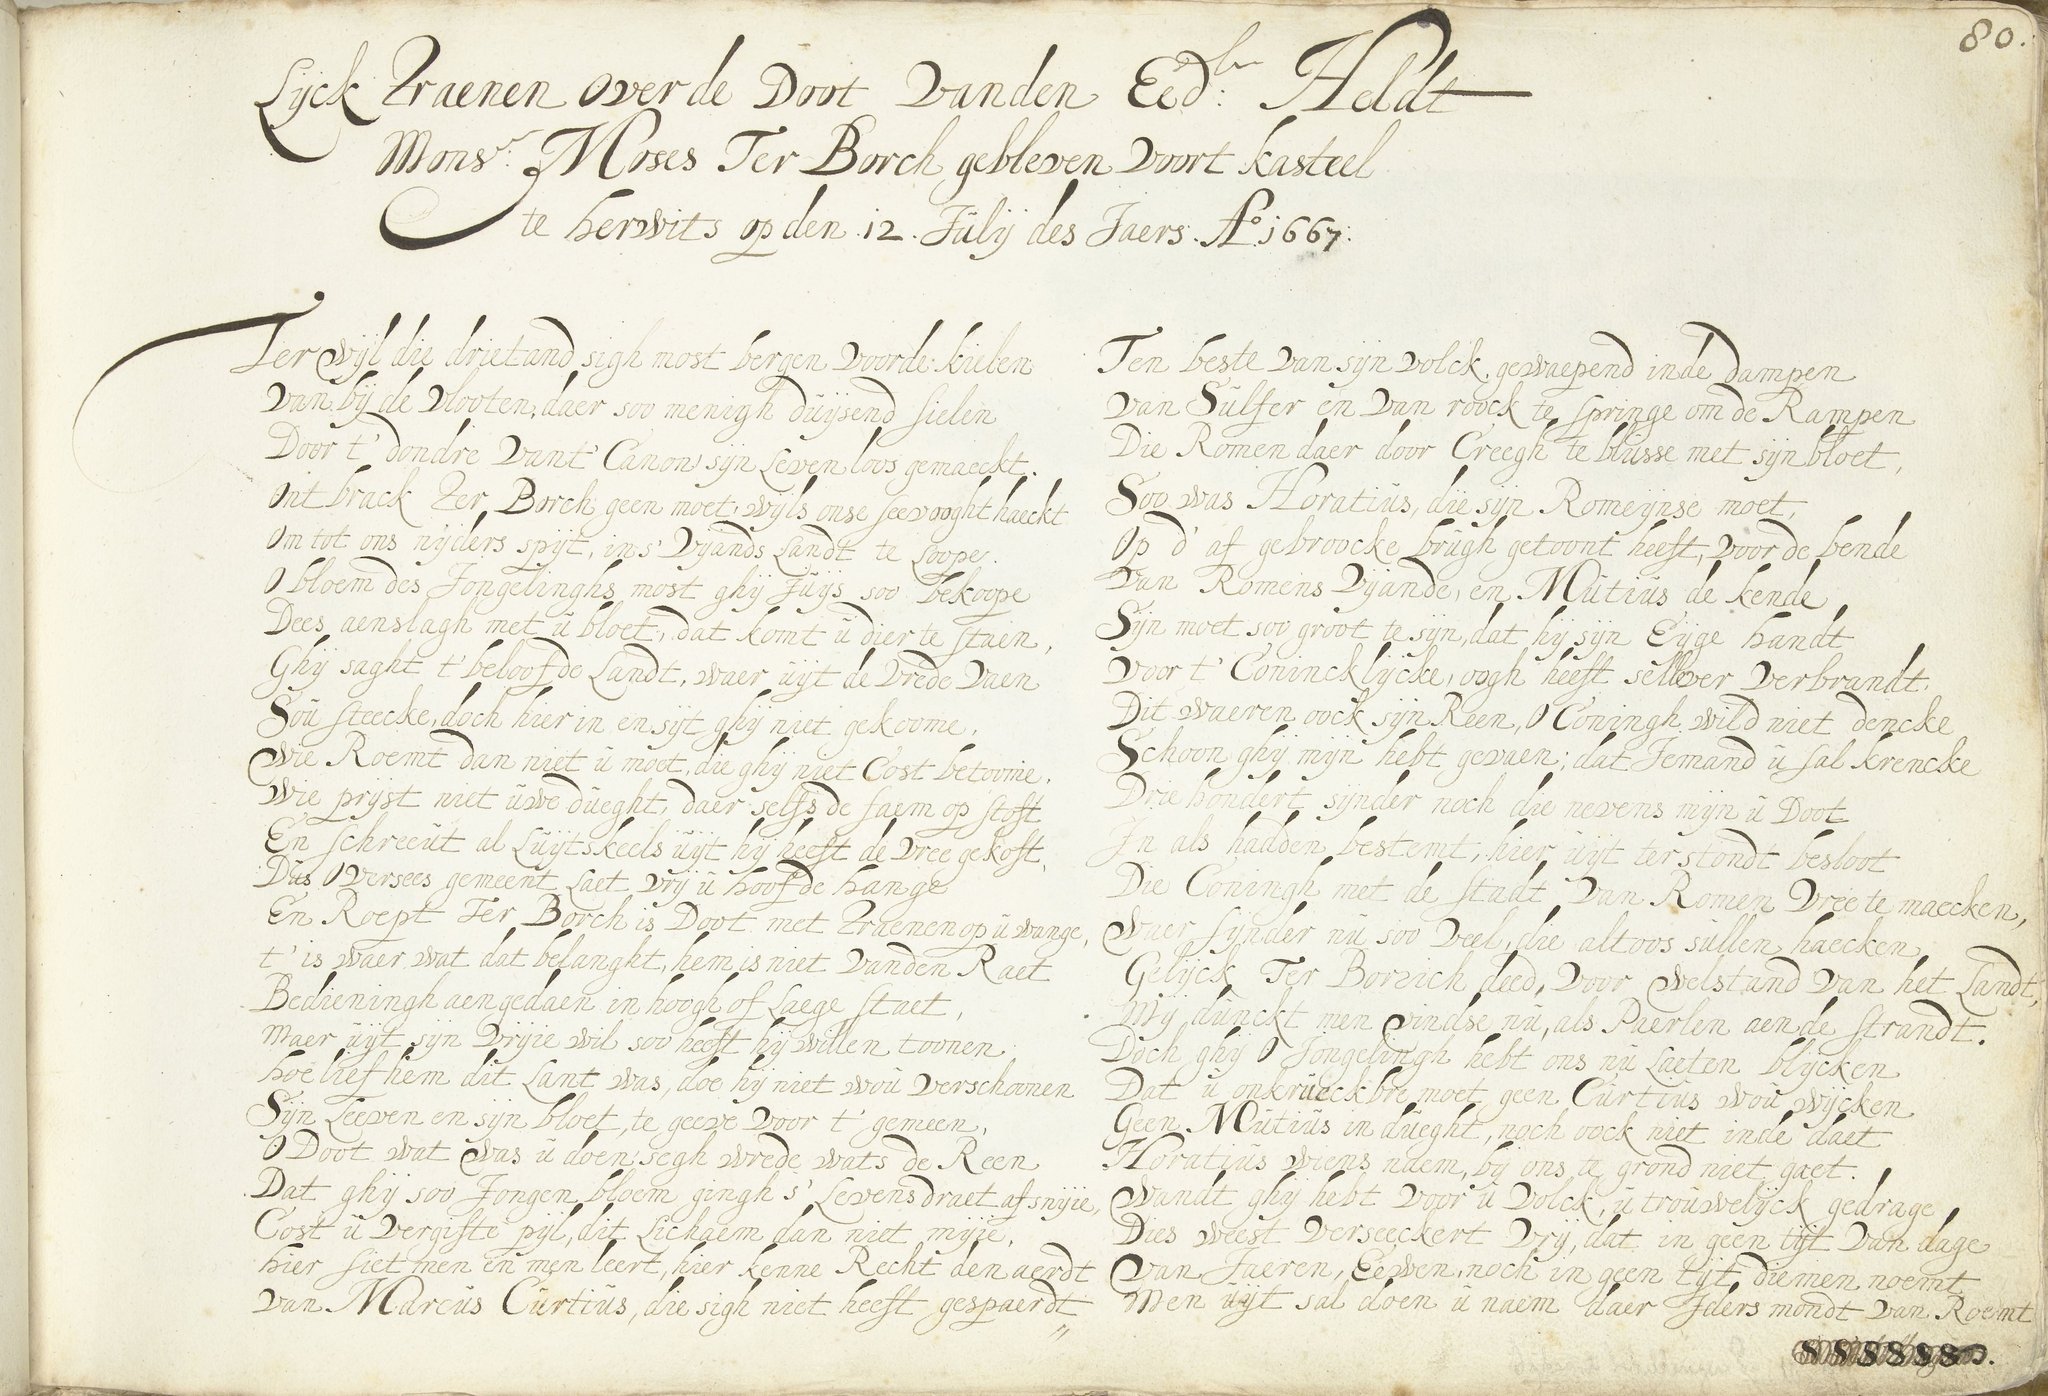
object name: poem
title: Rouwgedicht voor Moses ter Borch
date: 1667-1670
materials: ink, paper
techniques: writing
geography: zwolle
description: Gedicht in twee kolommen, ter nagedachtenis aan Moses ter Borch, omgekomen tijdens de Tweede Engelse Oorlog bij de kust van Harwich.